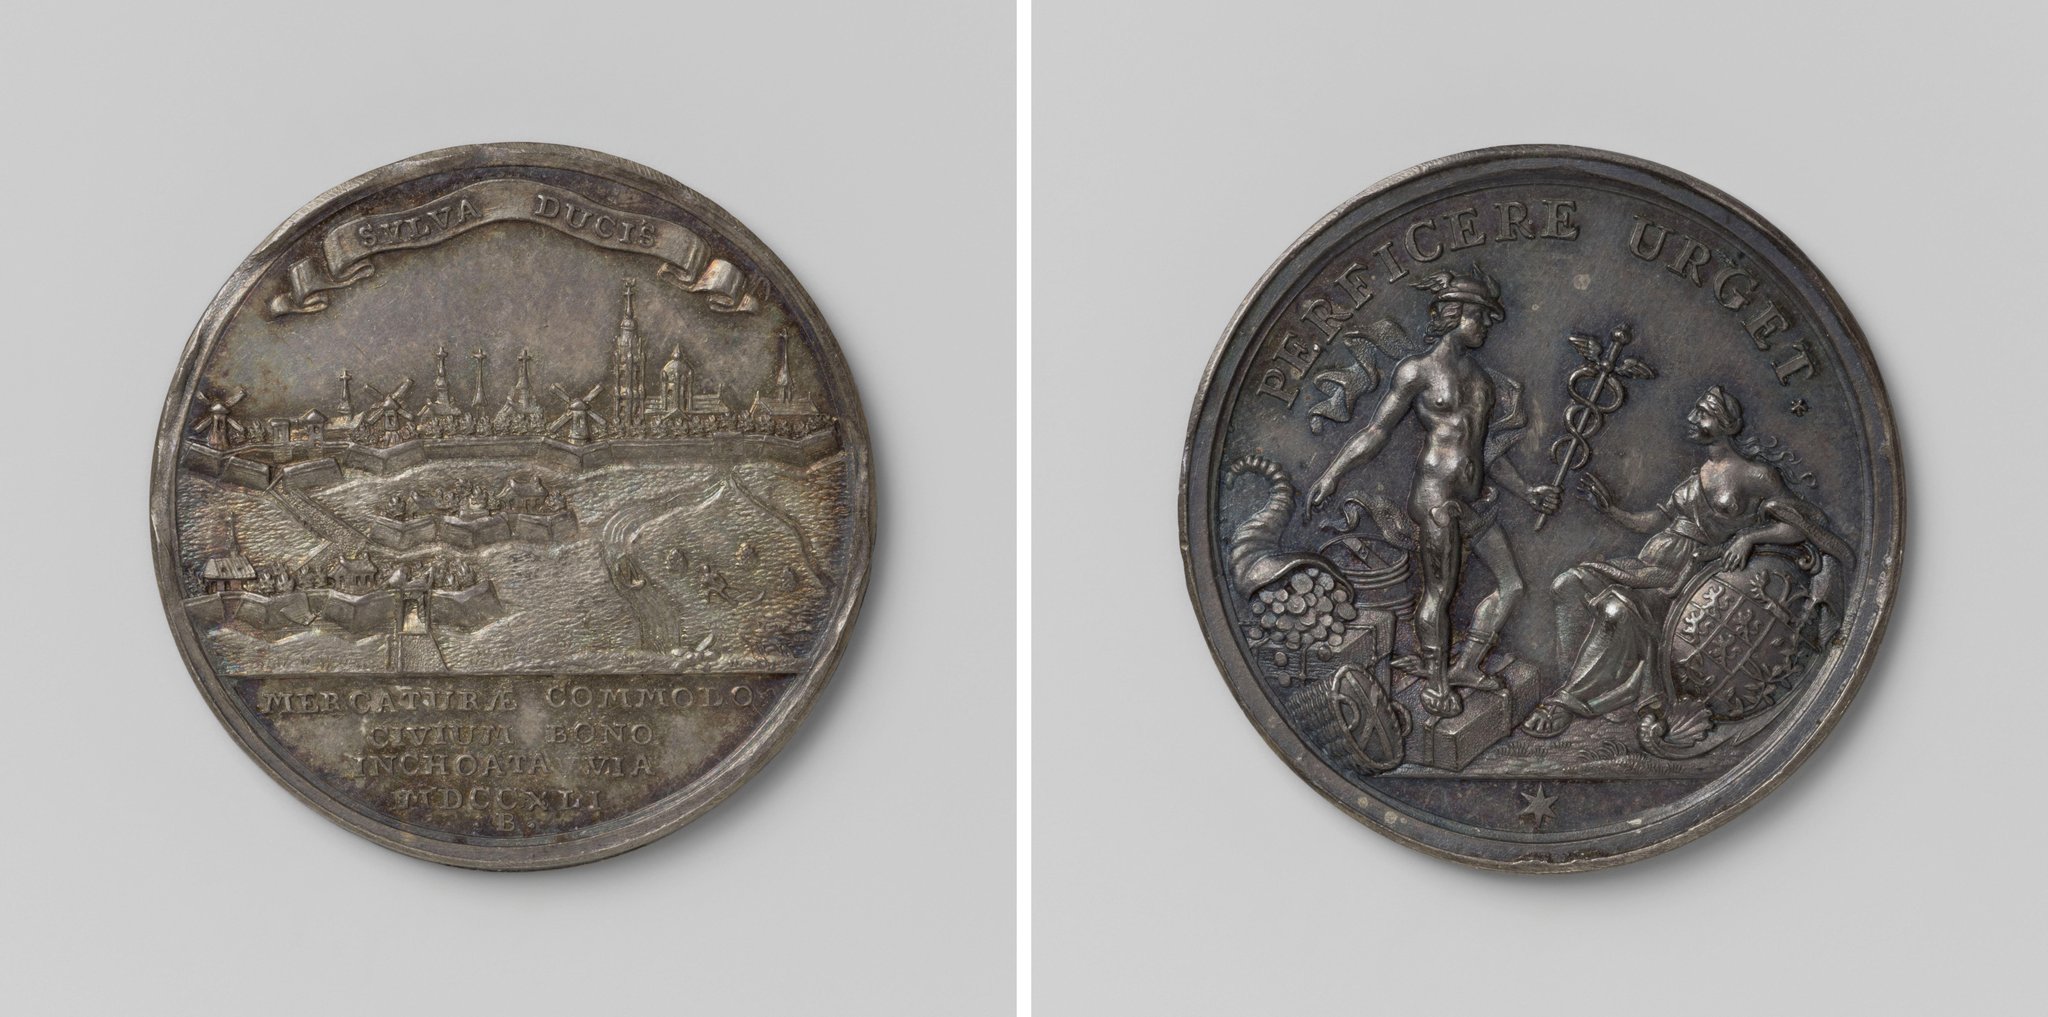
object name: council medal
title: 's-Hertogenbosch, vroedschapspenning op de aanleg van de steenweg van 's-Hertogenbosch naar Eindhoven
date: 1741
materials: silver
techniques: striking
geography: den bosch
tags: den bosch